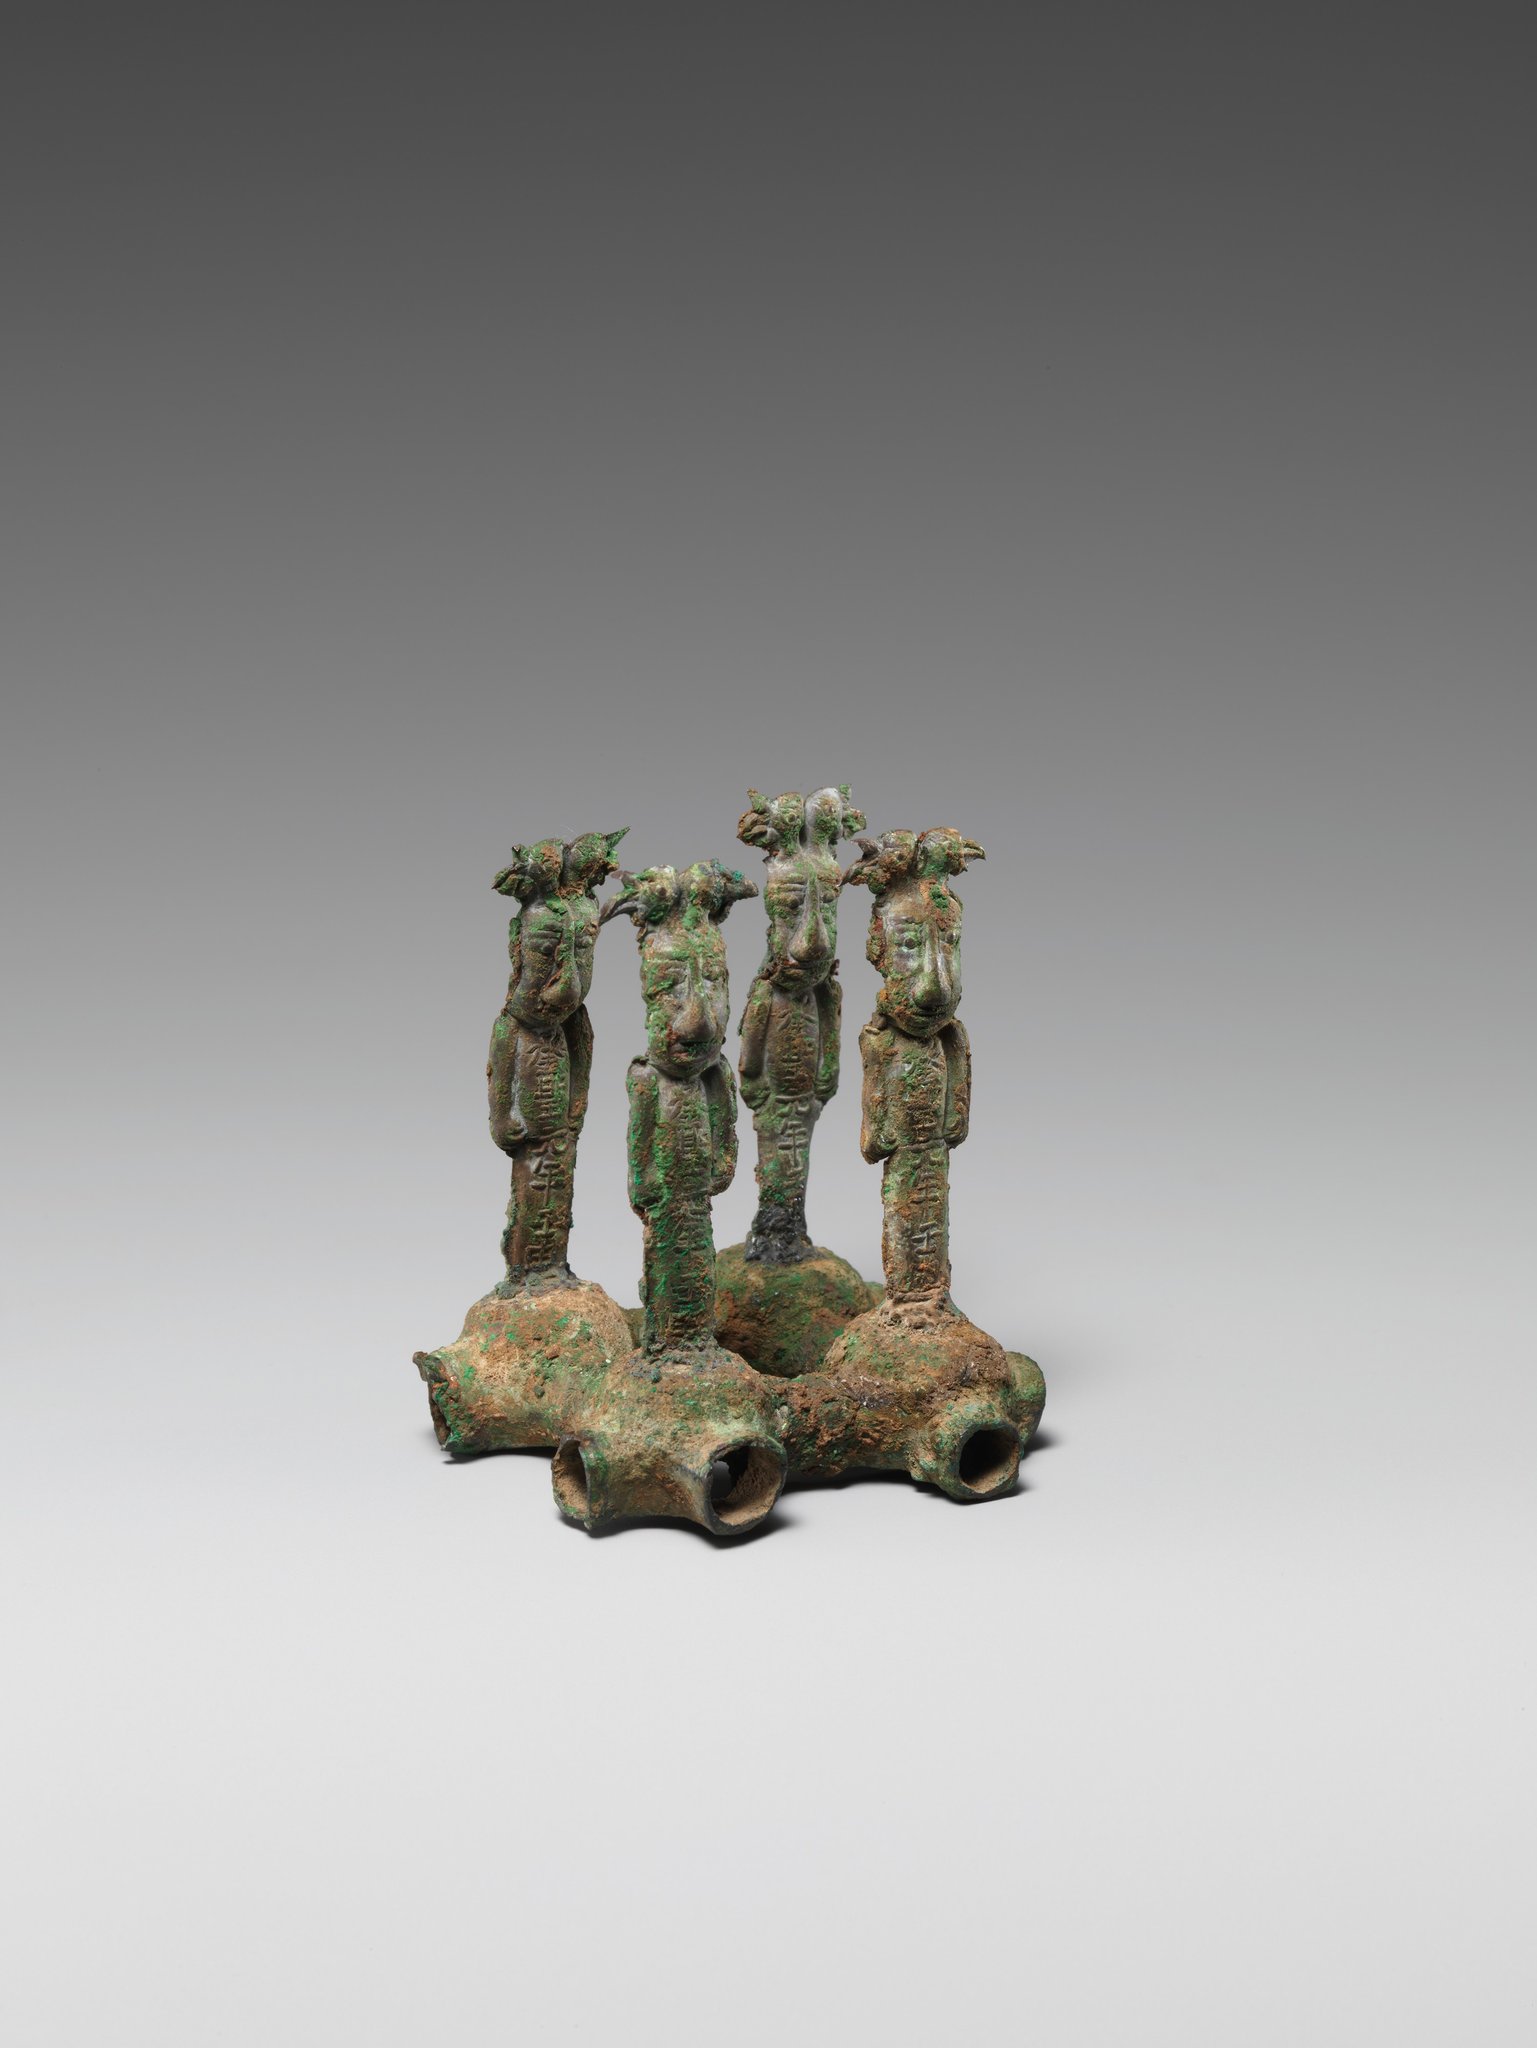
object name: cross tube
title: Small Cross Tube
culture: chinese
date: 1046-256 BCE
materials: bronze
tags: human figures